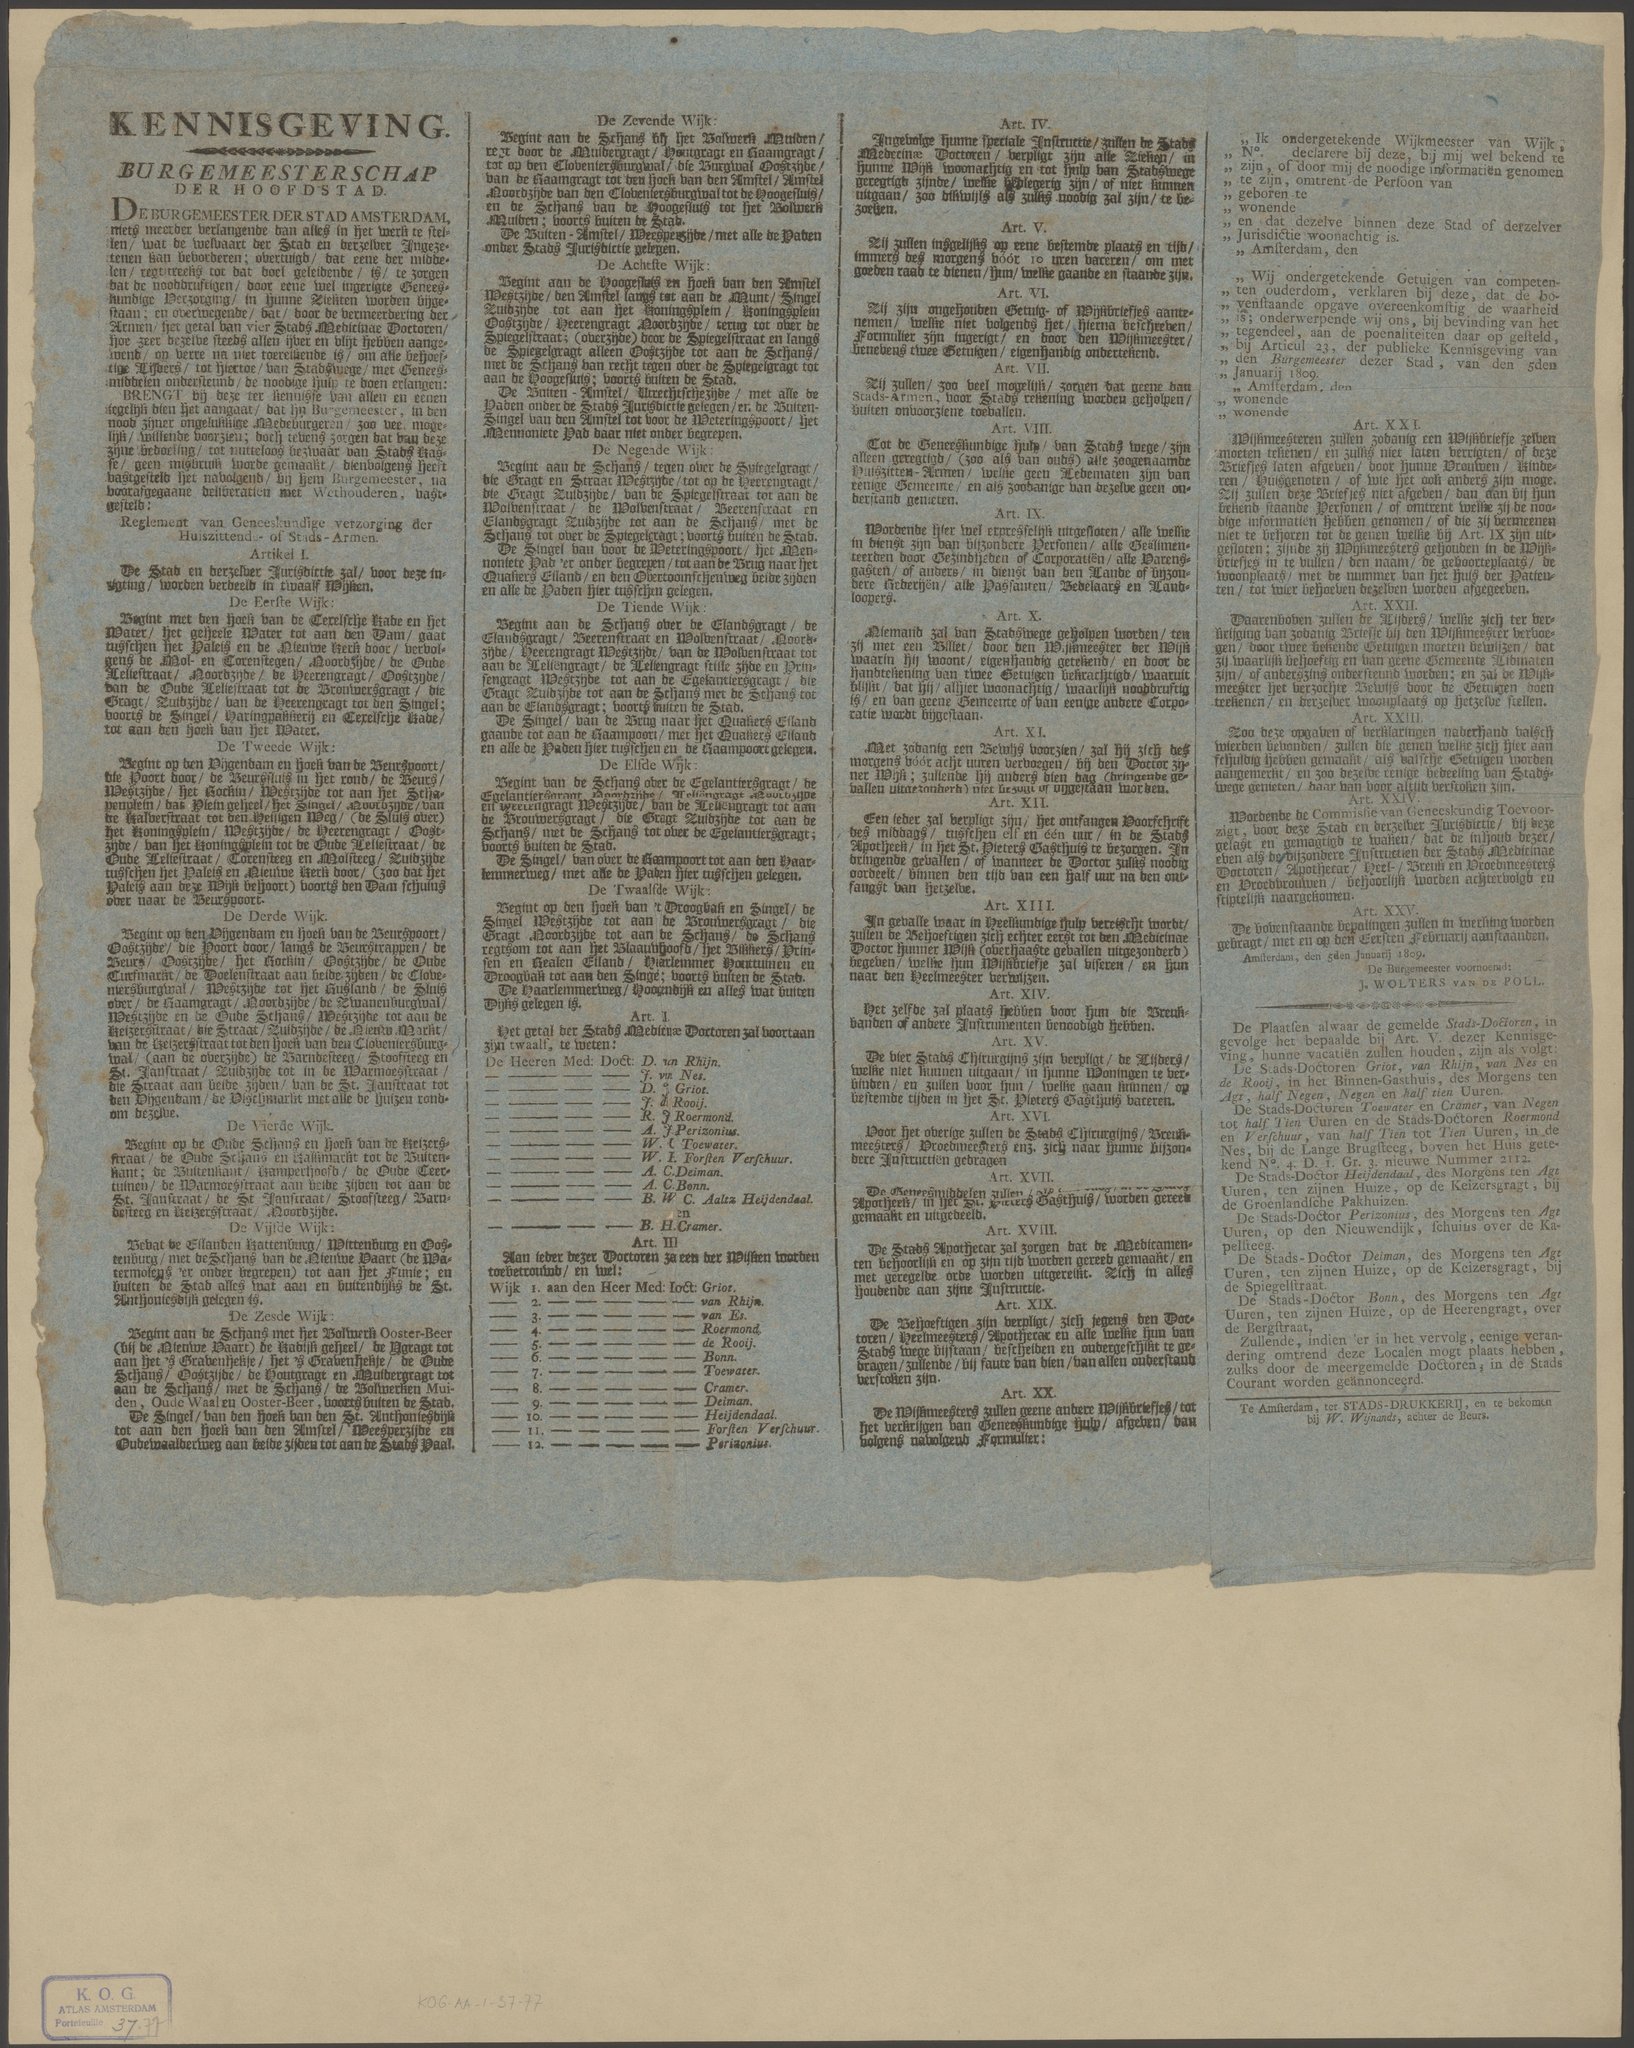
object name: pamphlet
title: Kennisgeving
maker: wijnand wijnands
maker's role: publisher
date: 1809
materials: paper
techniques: letterpress printing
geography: amsterdam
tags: physician, doctor, medical examination, medical treatment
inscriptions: collector's mark: Lugt 1641b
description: Onderwerpsrubriek binnen de Atlas Amsterdam: Armwezen en liefdadige instellingen: I. Stadsinrichtingen: Geneeskundige Dienst.